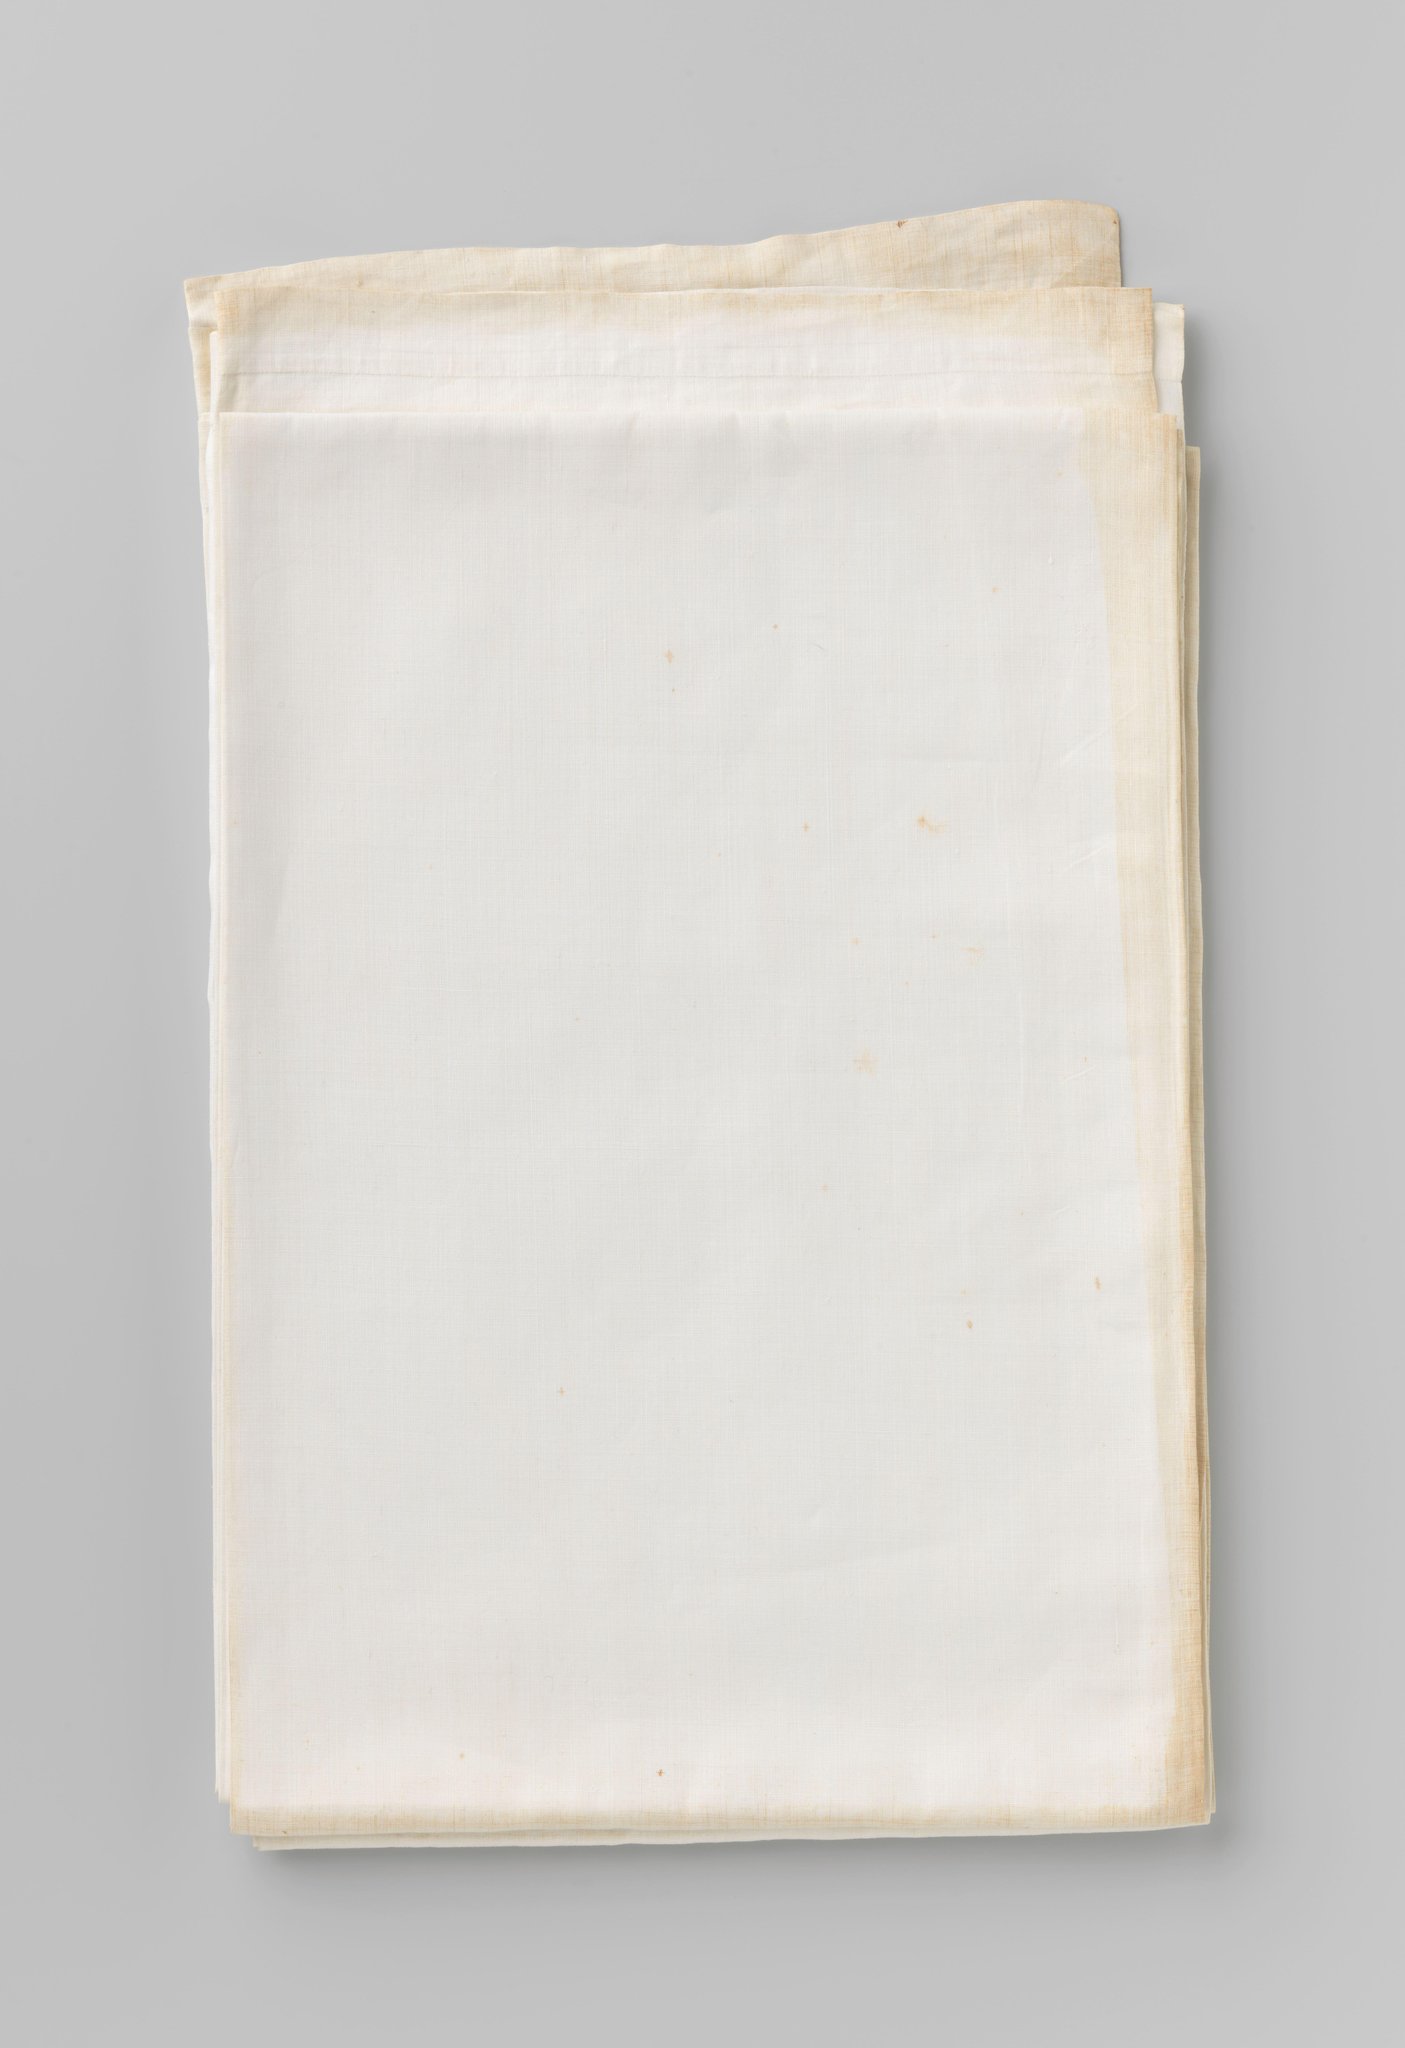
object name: beddenlaken, laken object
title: Laken. Merk: GS 12.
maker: Anonymous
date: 1692-1735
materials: linen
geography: northern netherlands